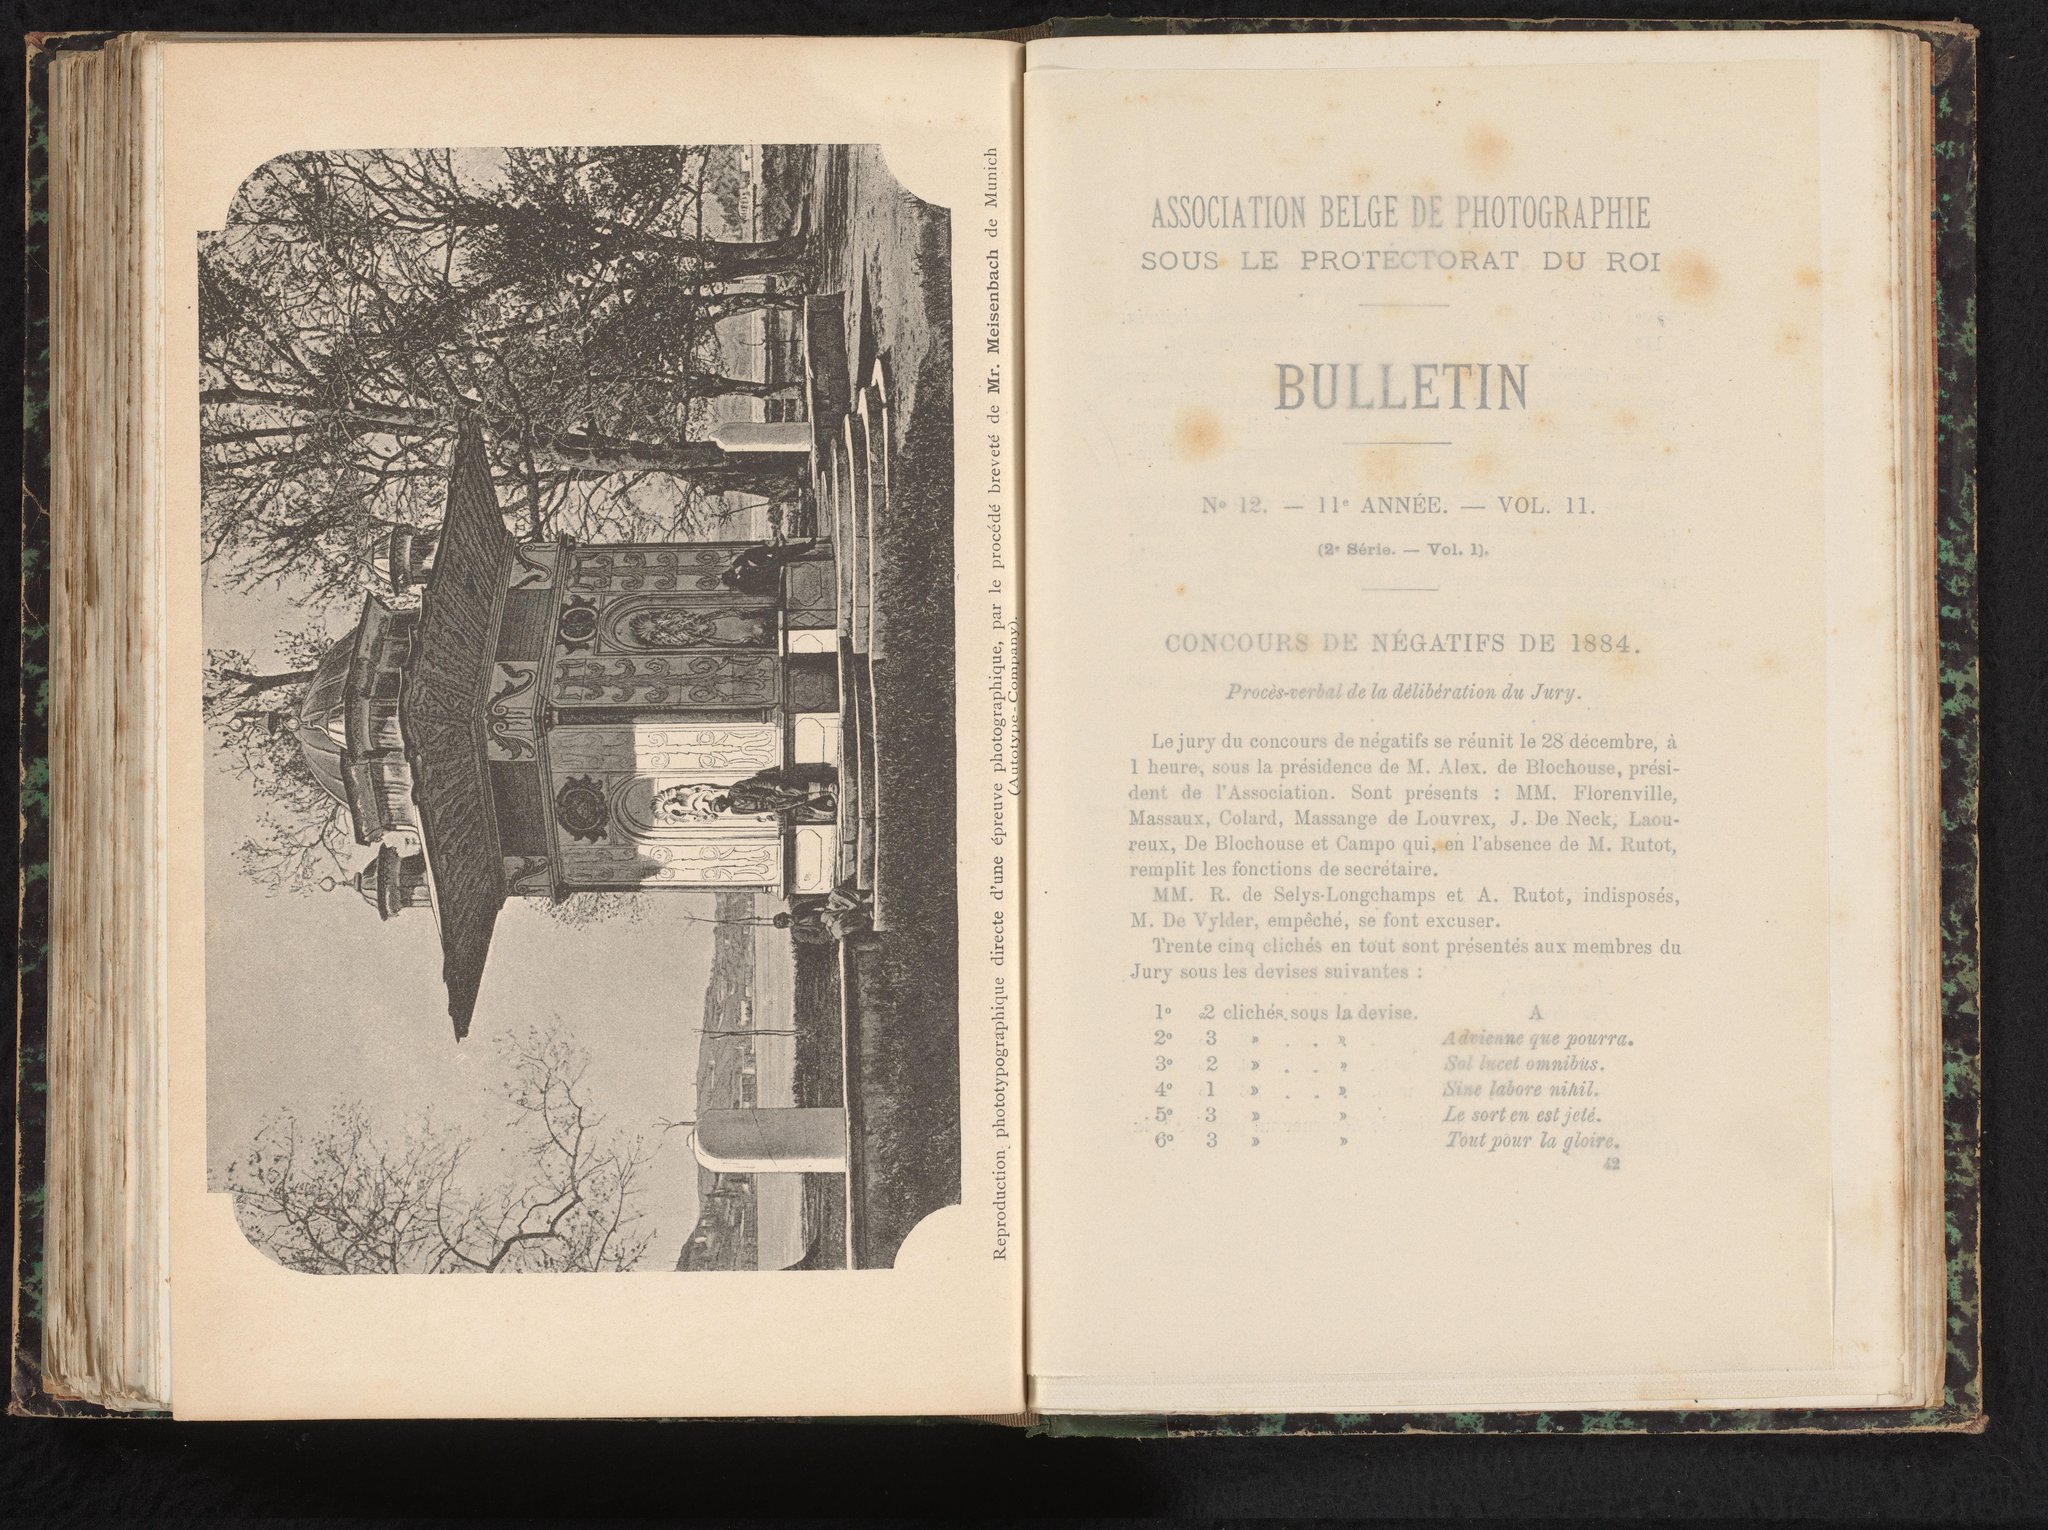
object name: reproduction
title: Reproductie van een prent naar een schilderij van een hond door Henriëtte Ronner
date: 1879-1884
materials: paper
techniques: photoaquatint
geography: brussels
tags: dog